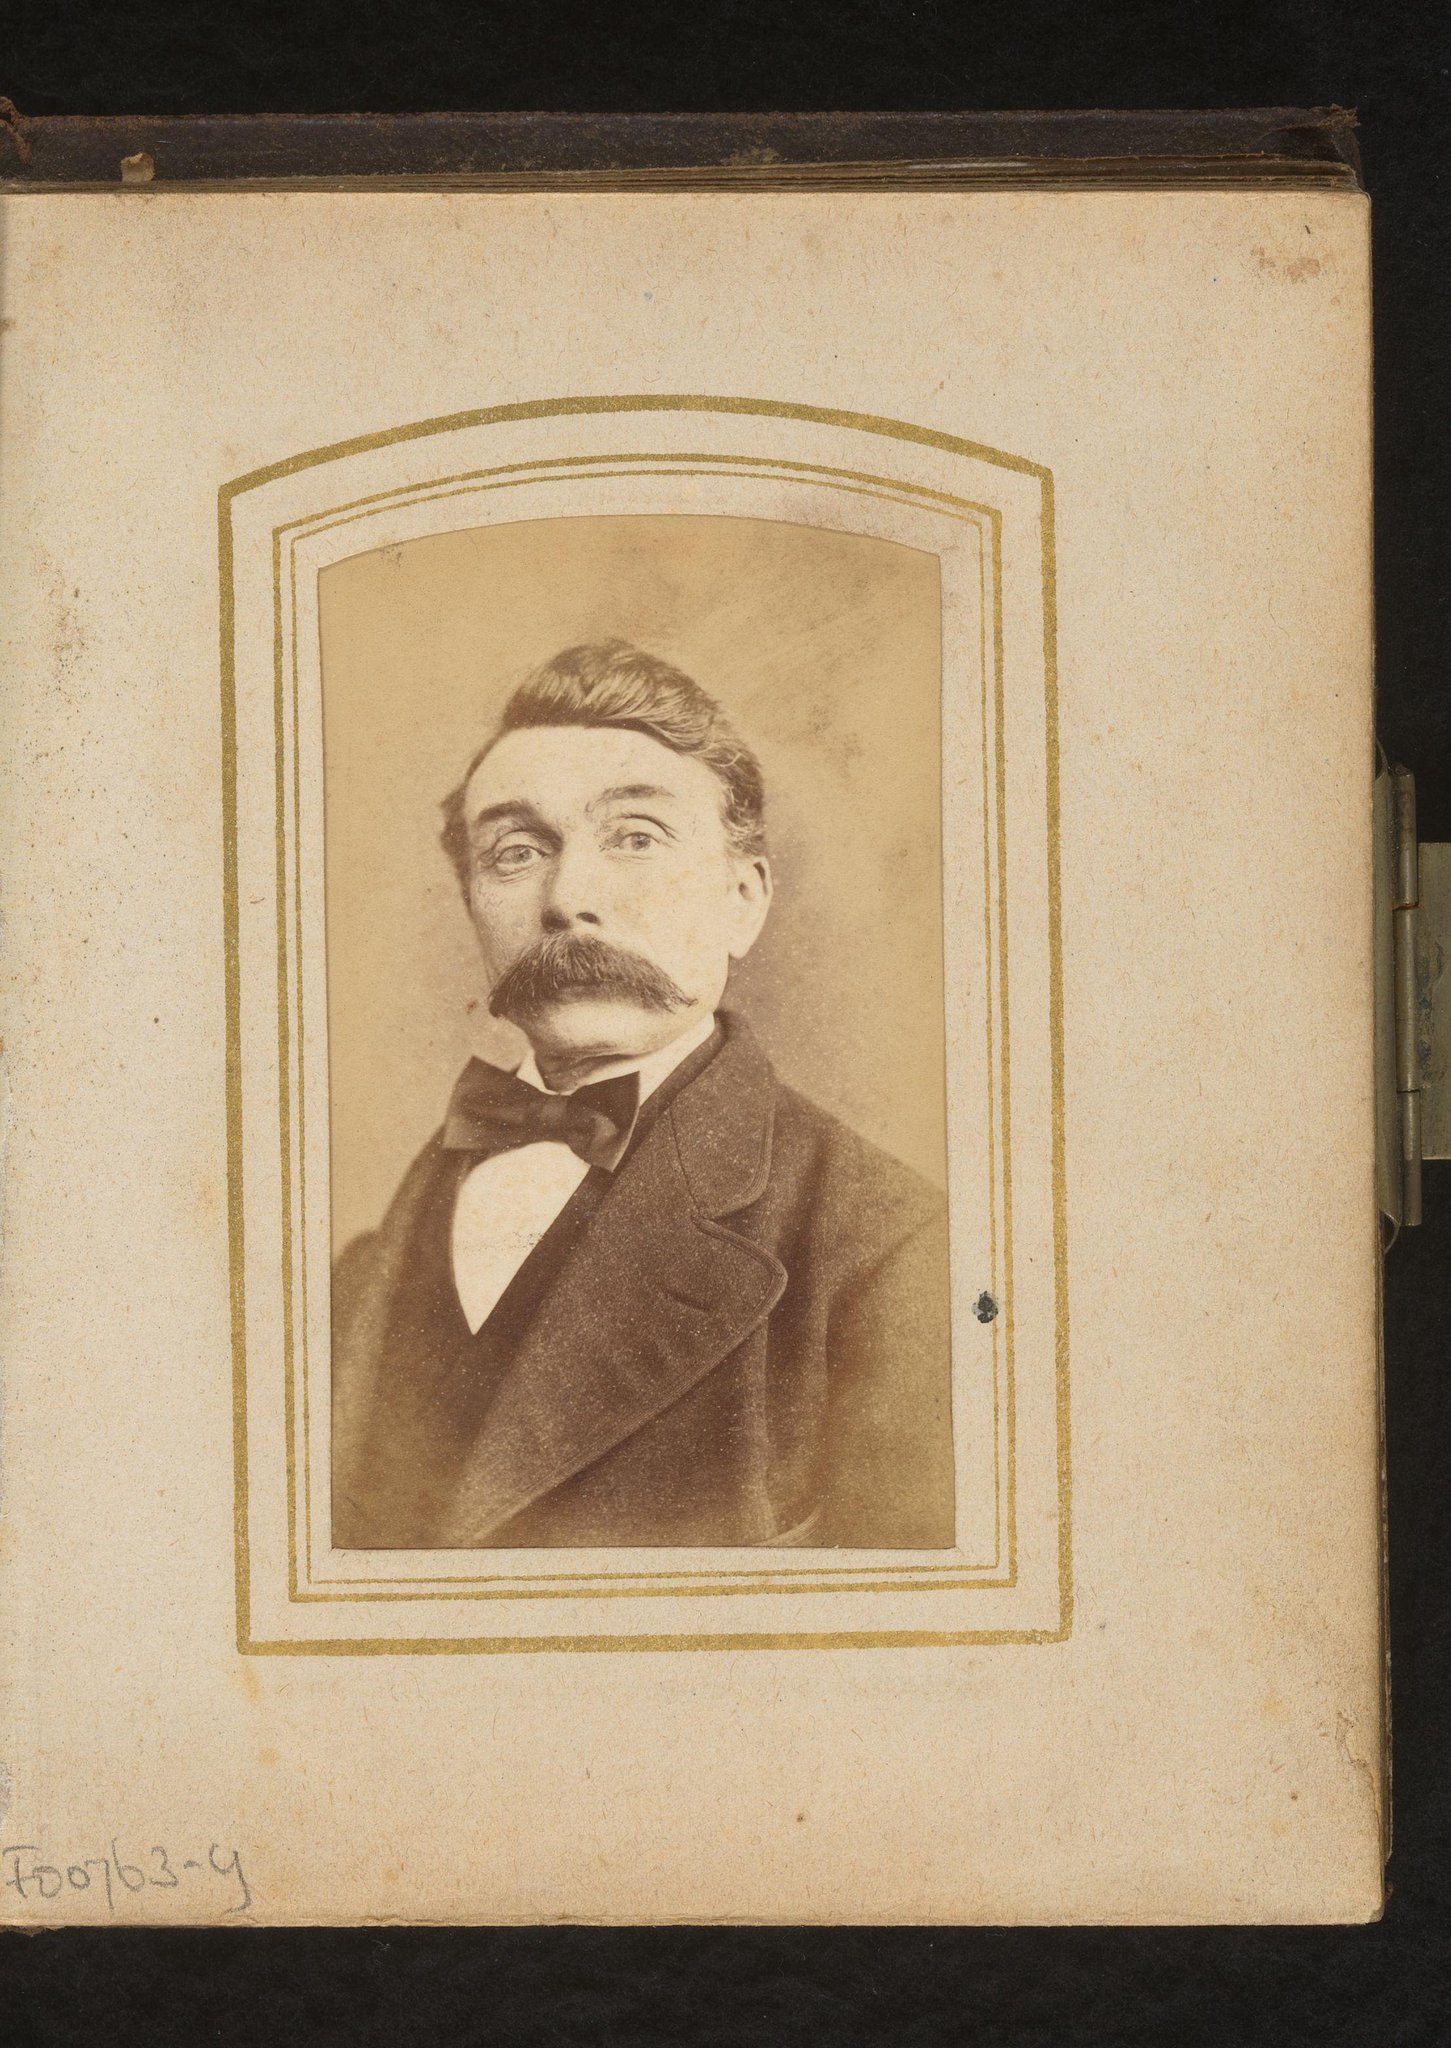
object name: album leaf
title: Portret van een man met snor en vlinderstrik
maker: johannes wilhelmus karsses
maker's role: draughtsman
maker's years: 1841-1875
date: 1856-1875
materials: cardboard, photographic support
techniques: albumen print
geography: groningen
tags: moustache, historical persons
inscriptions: inscription: ‘J. W. KARSSES/ Kunstschilder en Photograaf/ Buitende Heerepoort/ O. Z. Heereweg Y. 513/ Groningen./ Voor nabestelling blijft deze plaat bewaard.’